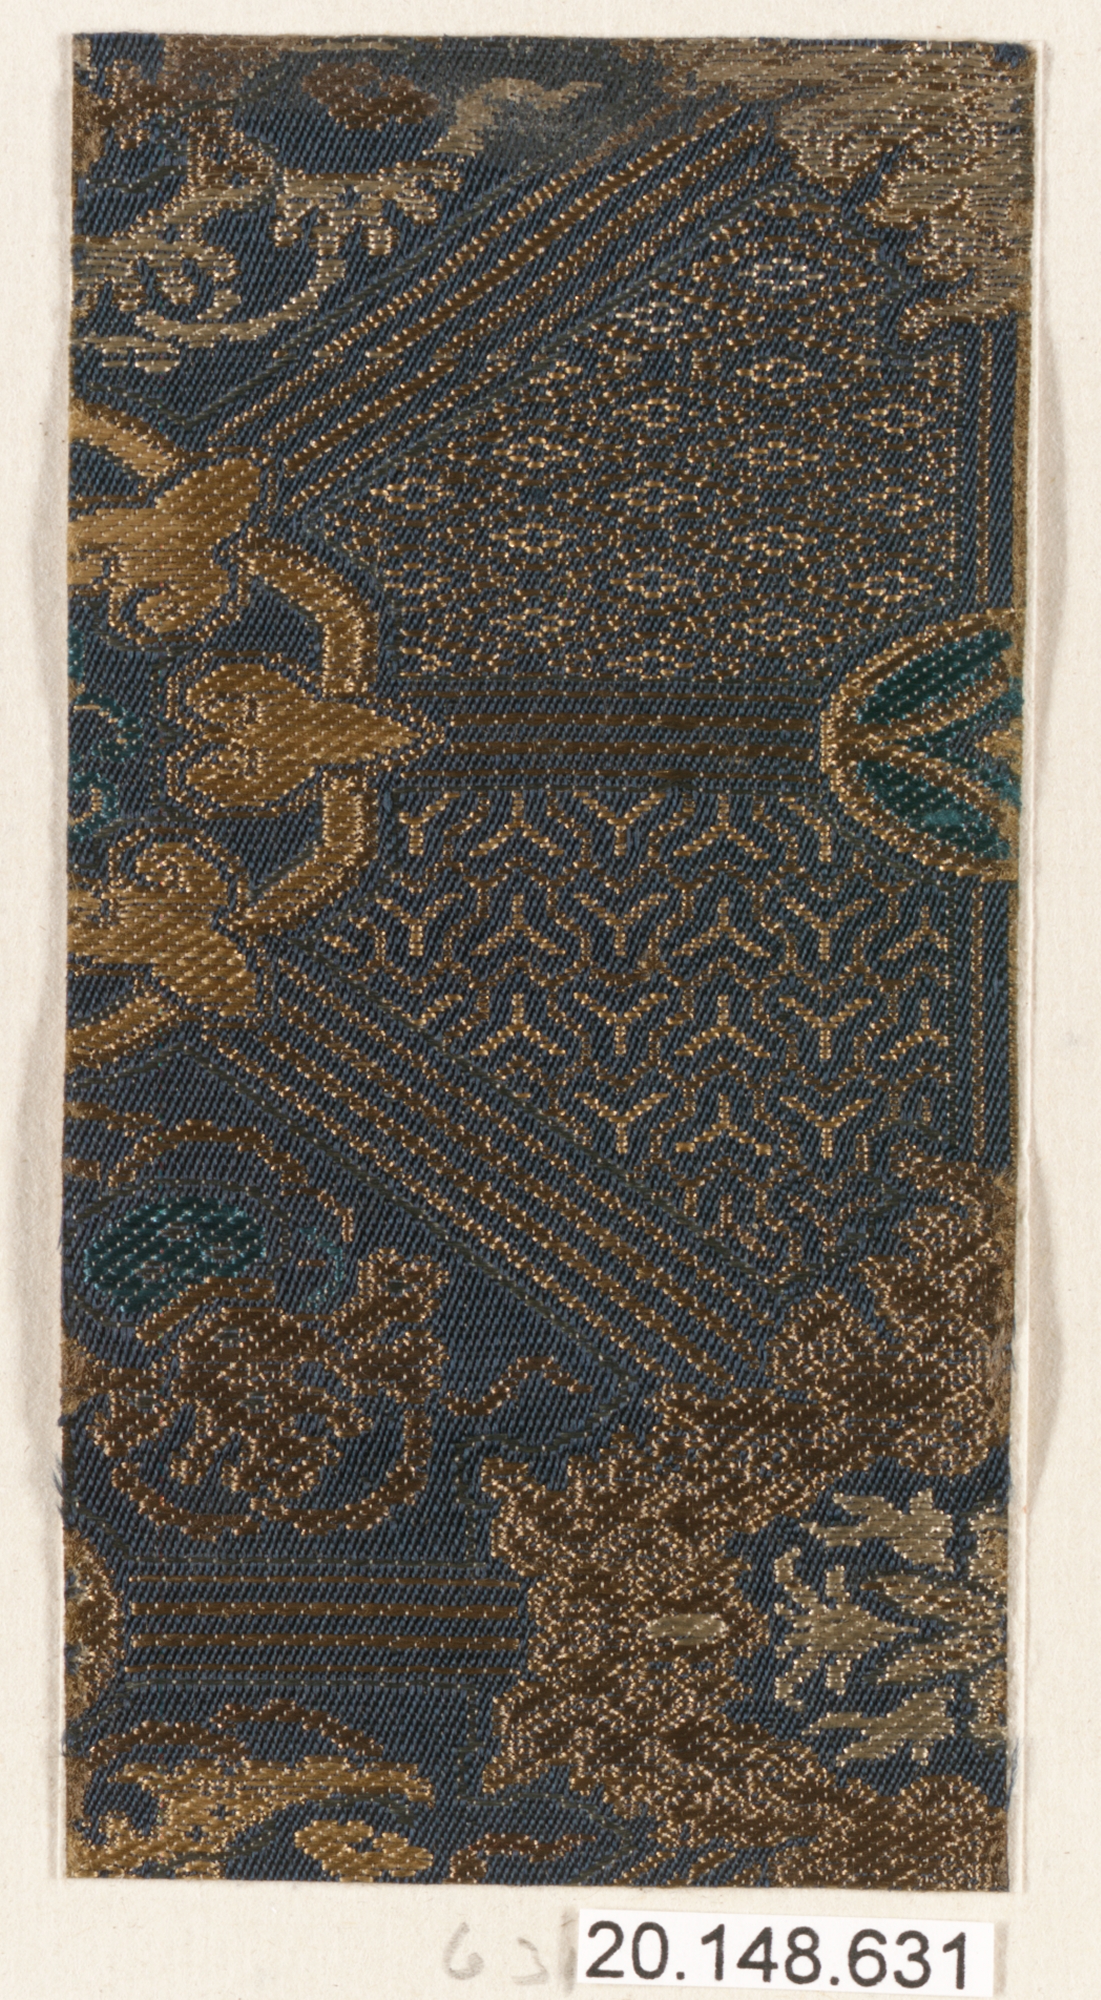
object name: piece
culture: japanese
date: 1701-1800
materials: silk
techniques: compound weave